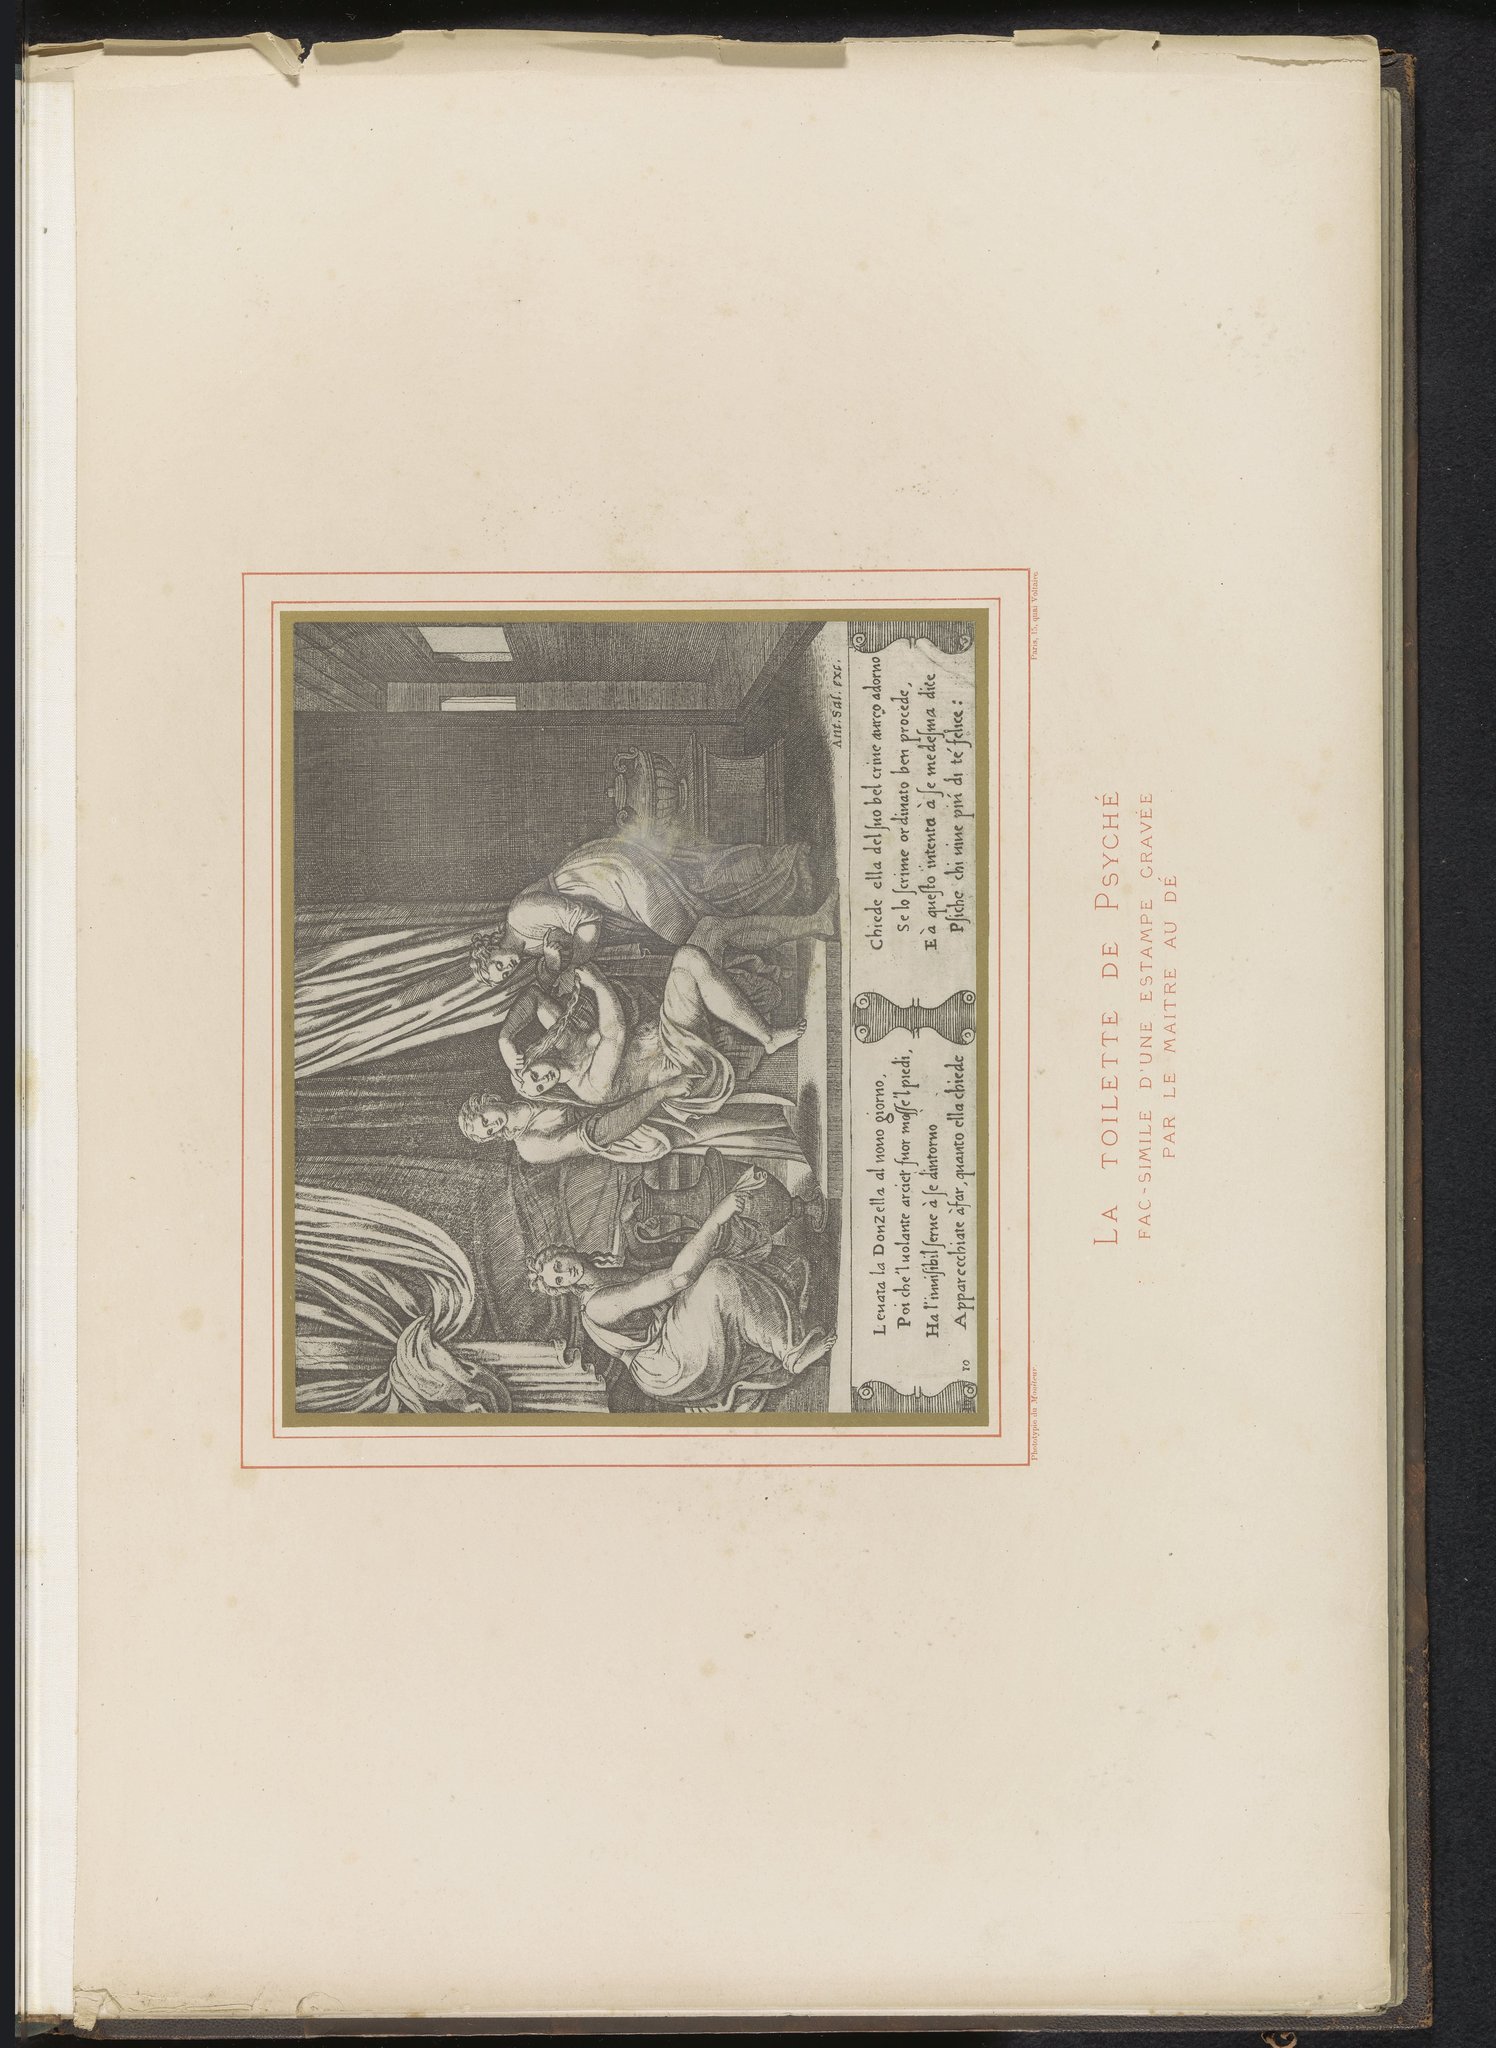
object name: page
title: Fotoreproductie van een gravure, voorstellende het toilet van Psyche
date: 1876-1883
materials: paper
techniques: photograph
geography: paris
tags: psyche is attended by invisible hands; the toilet of psyche